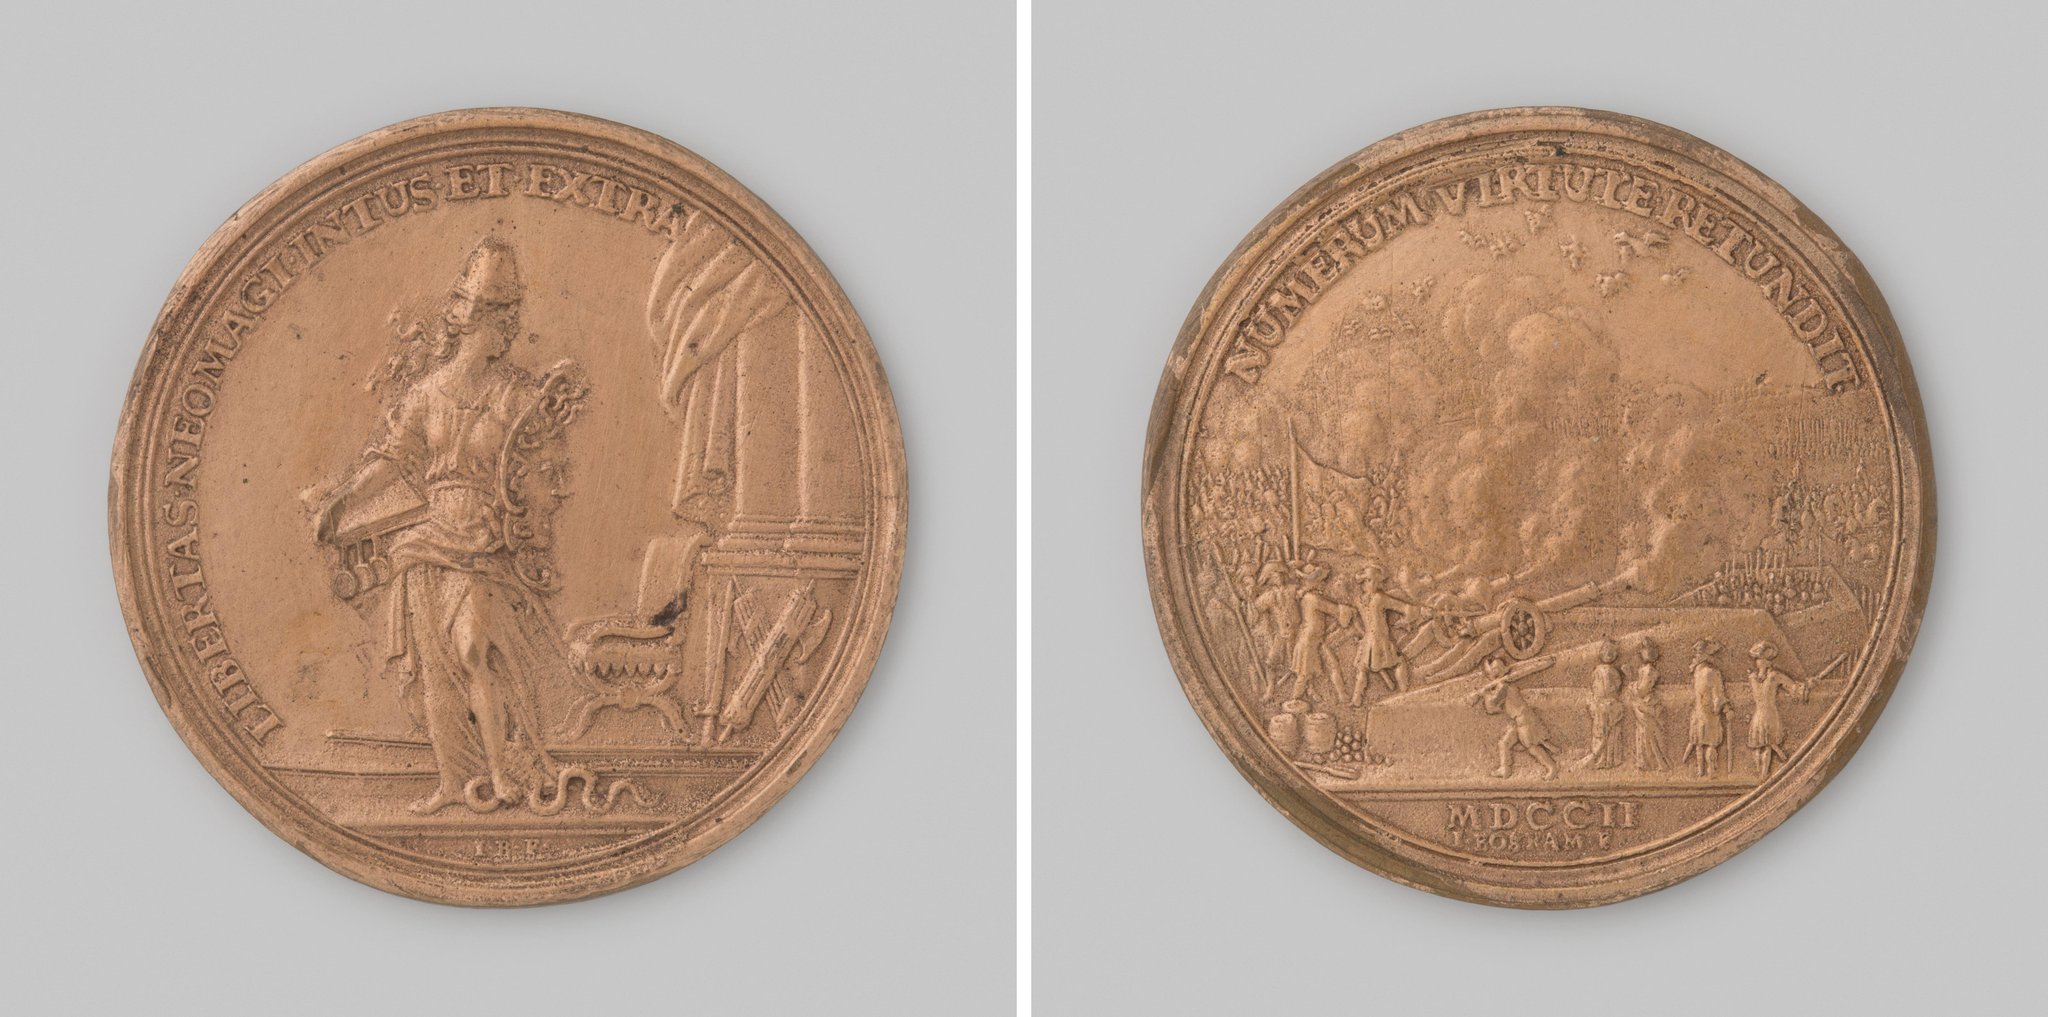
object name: history medal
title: Mislukte aanval van Frankrijk op Nijmegen 1702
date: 1702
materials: bronze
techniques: casting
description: Bronzen gegoten penning, op de voorzijde Nijmegen als Pallas met Gorgoneion en een gezegelde oorkonde, een slang vertredend, met omschrift, op de keerzijde de beschieting der Franse troepen vanuit Nijmegen, met omschrift, en afsnedetekst.